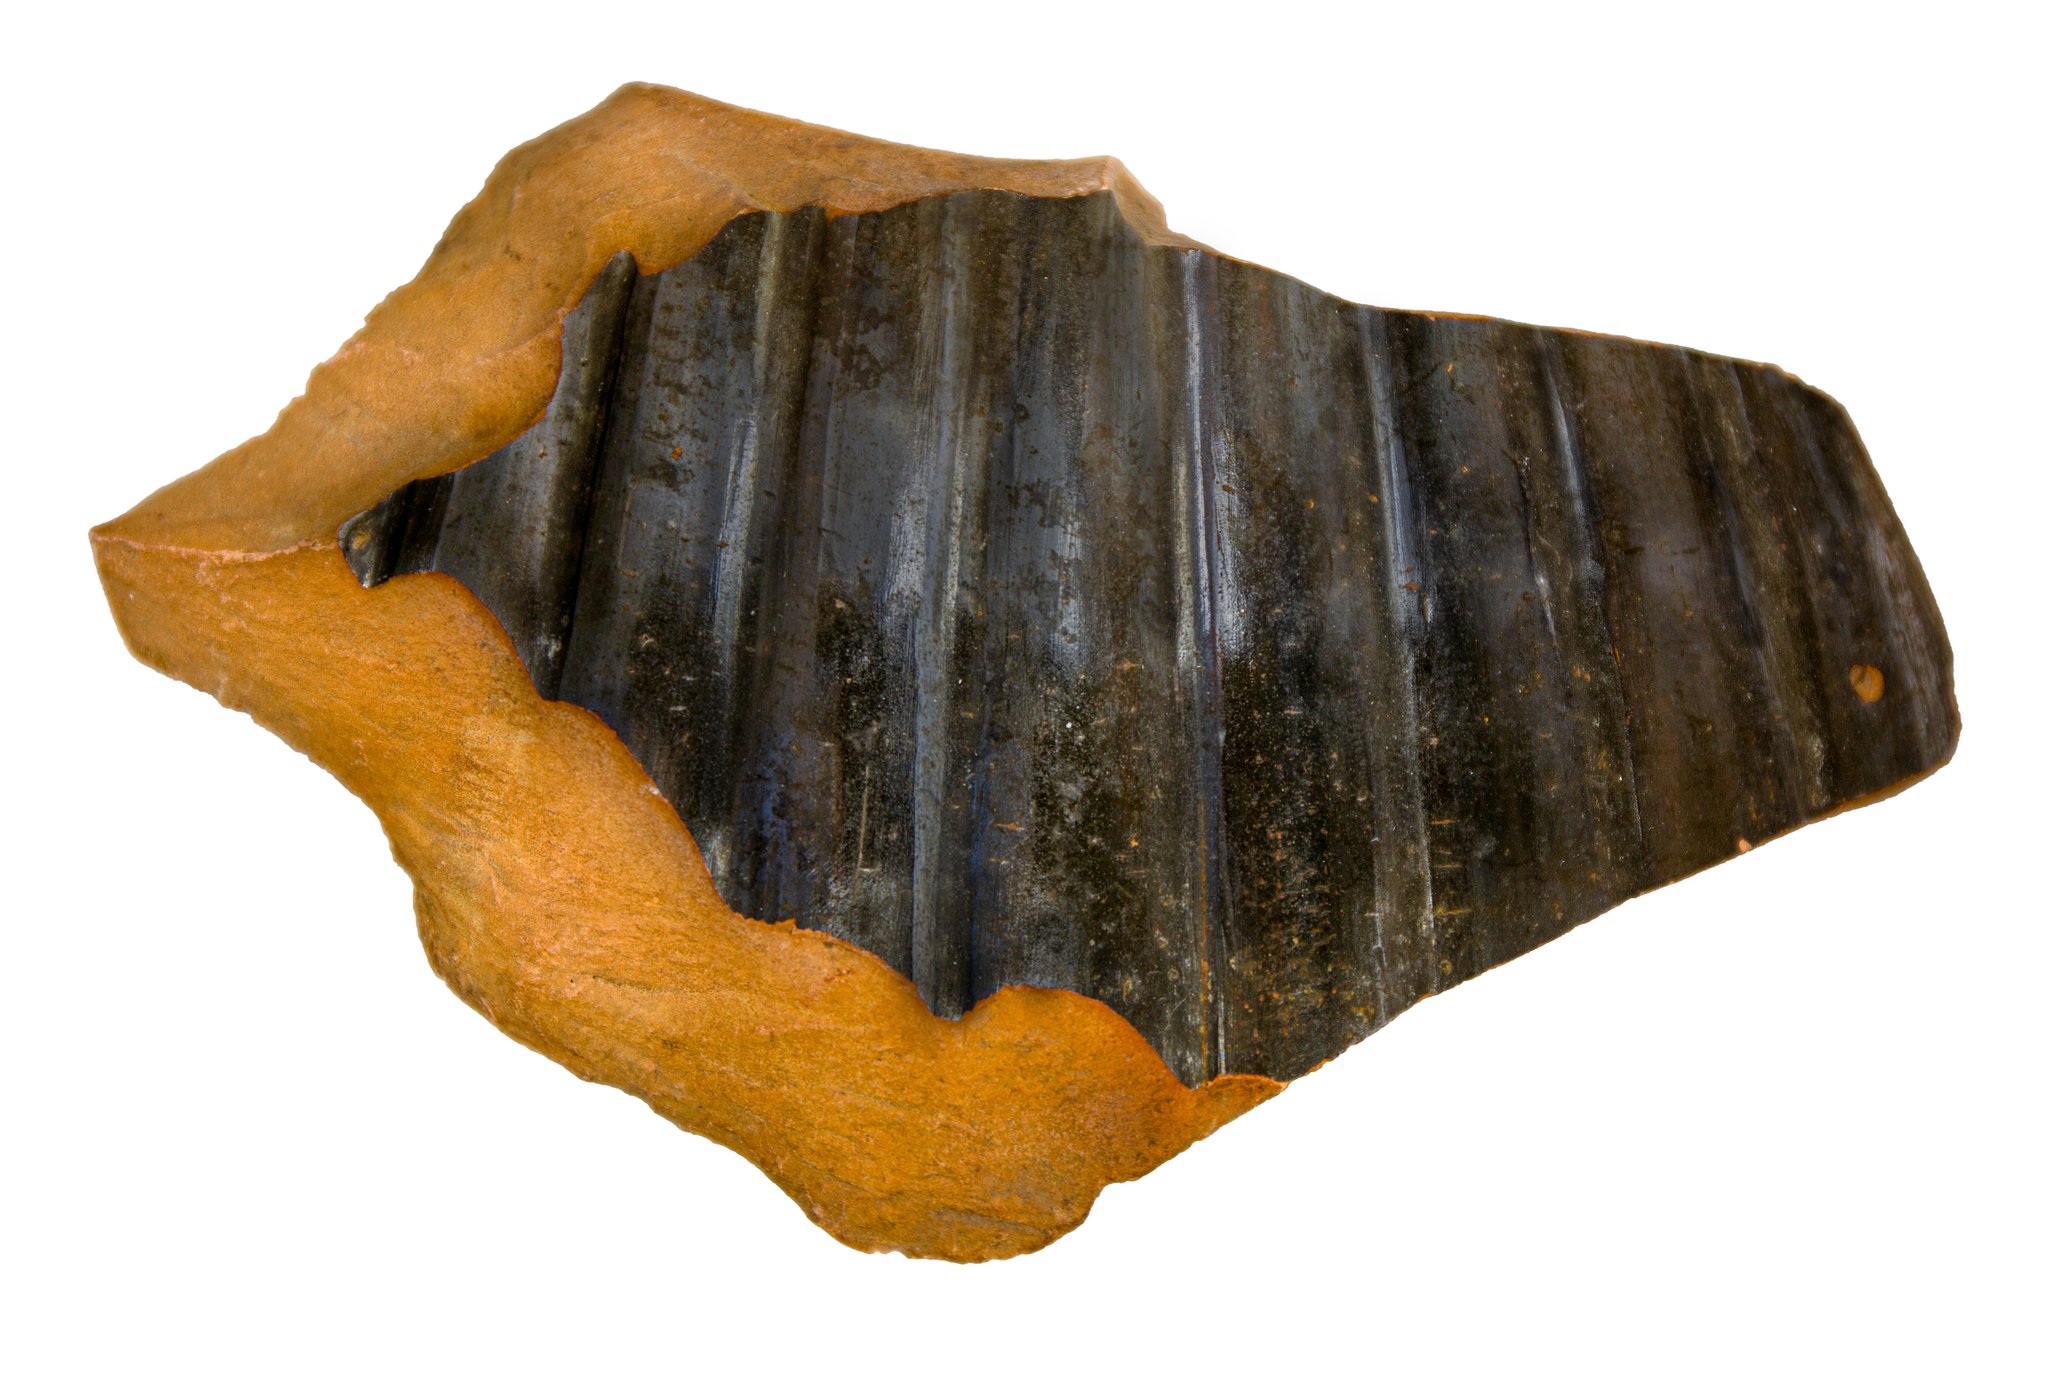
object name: volute krater fragment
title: Volute-krater fragment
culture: greek, south italian, apulian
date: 400-350 BCE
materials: terracotta